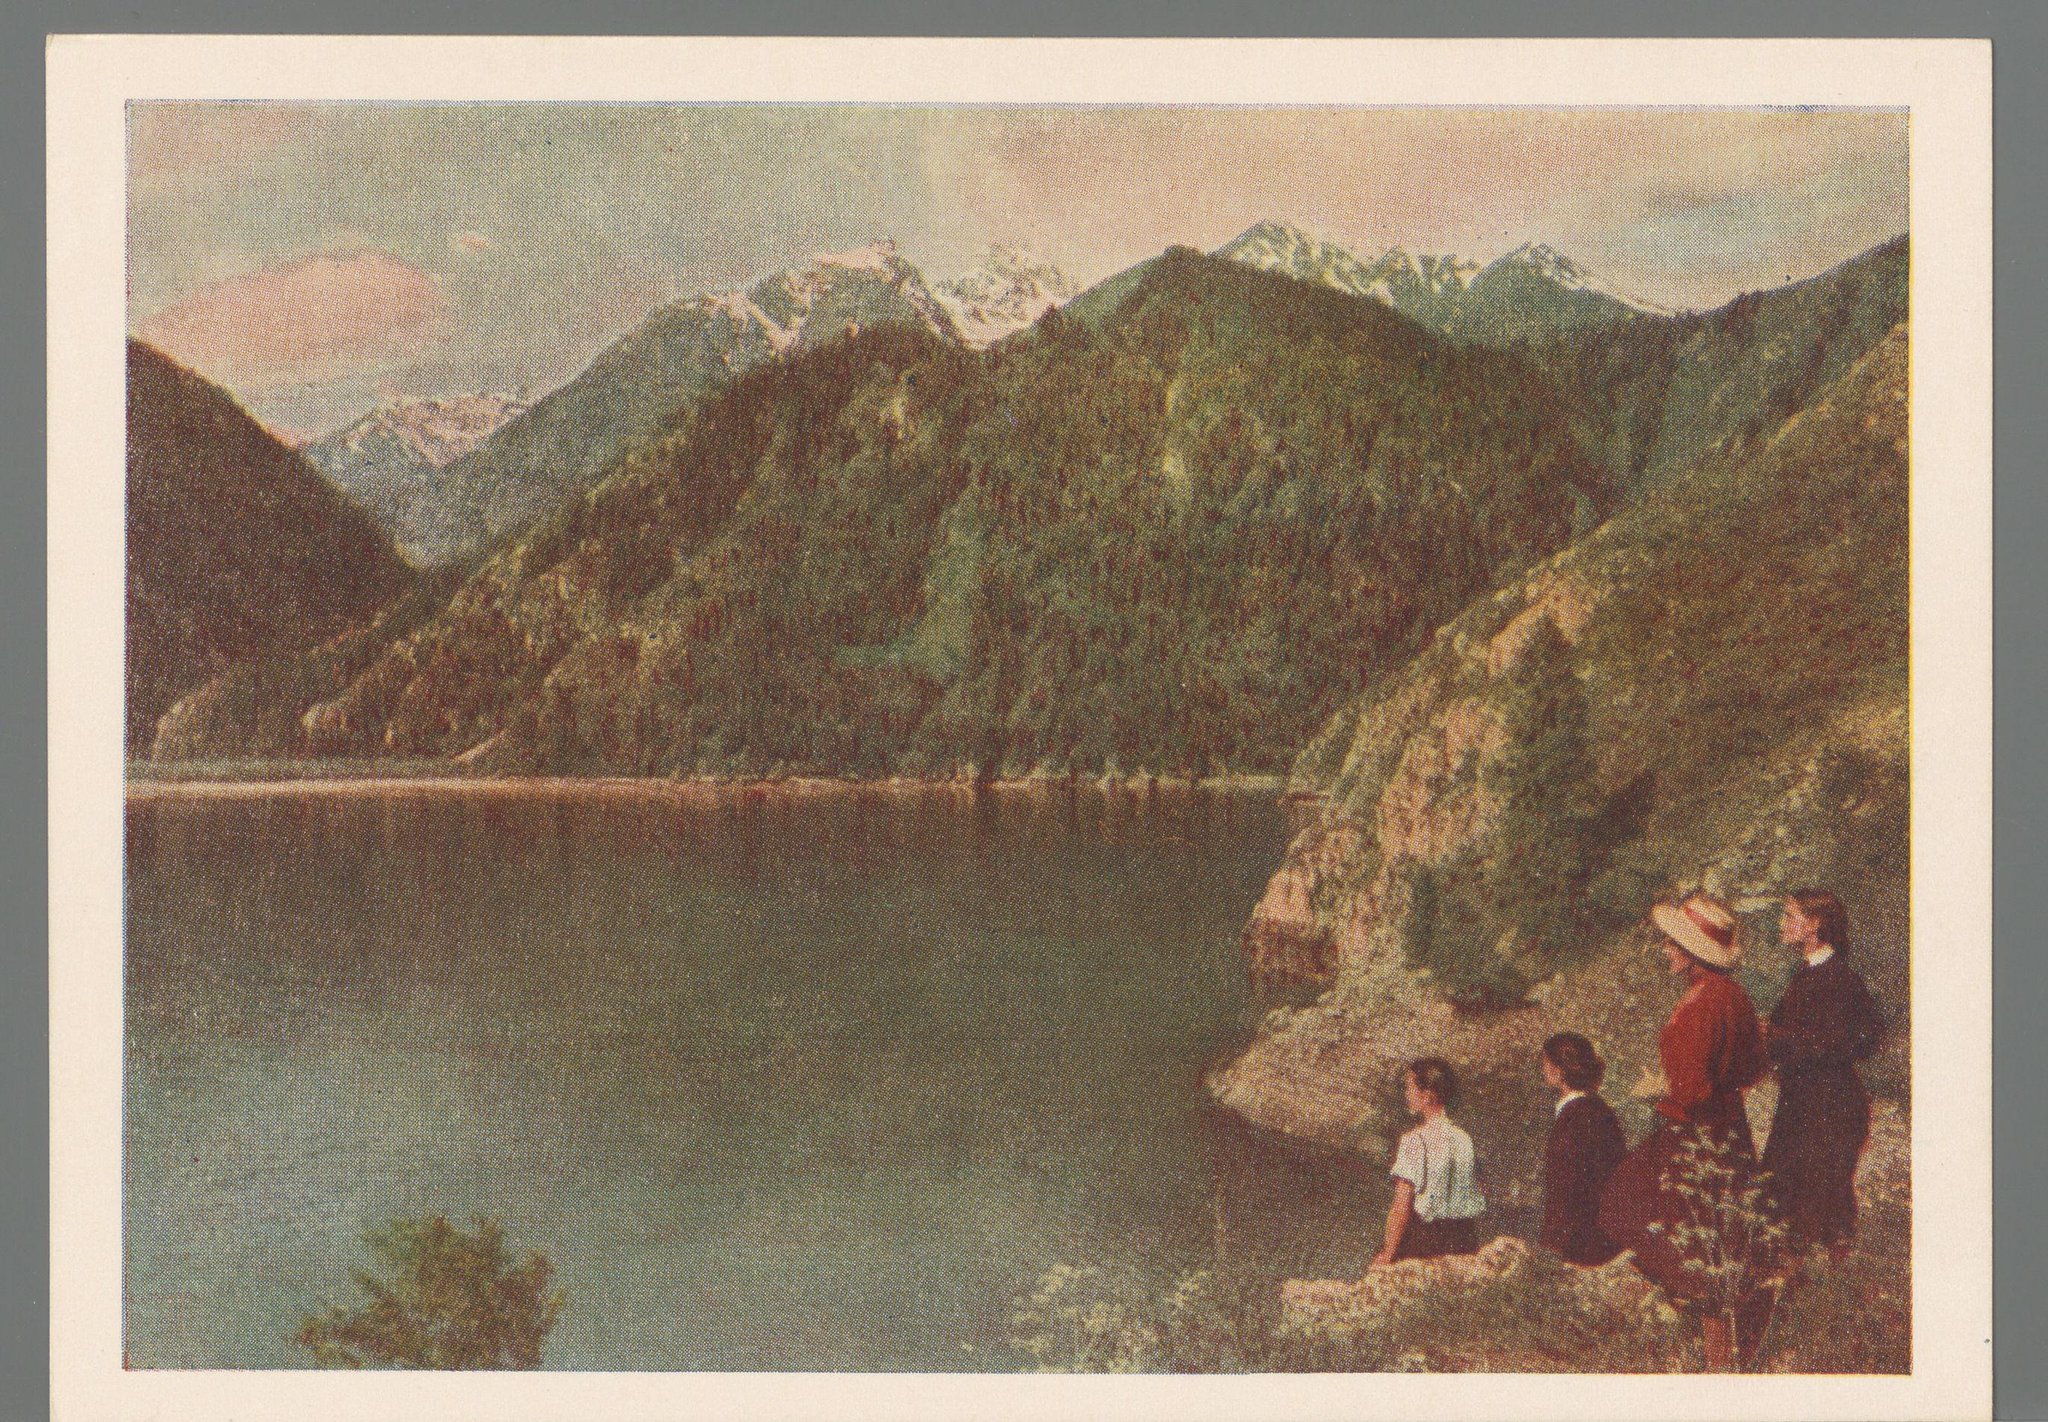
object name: ansichtkaart, prentbriefkaart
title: Kazakh S.S.R. Lake Issik / R.S.S. de Kazakhie. Alma-Ata. Lac Issik / Kasachische SSR. See Issik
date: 1956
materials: cardboard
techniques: color autotype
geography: moscow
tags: lake, mountains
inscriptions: date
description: De titel op object staat ook in het Russisch.